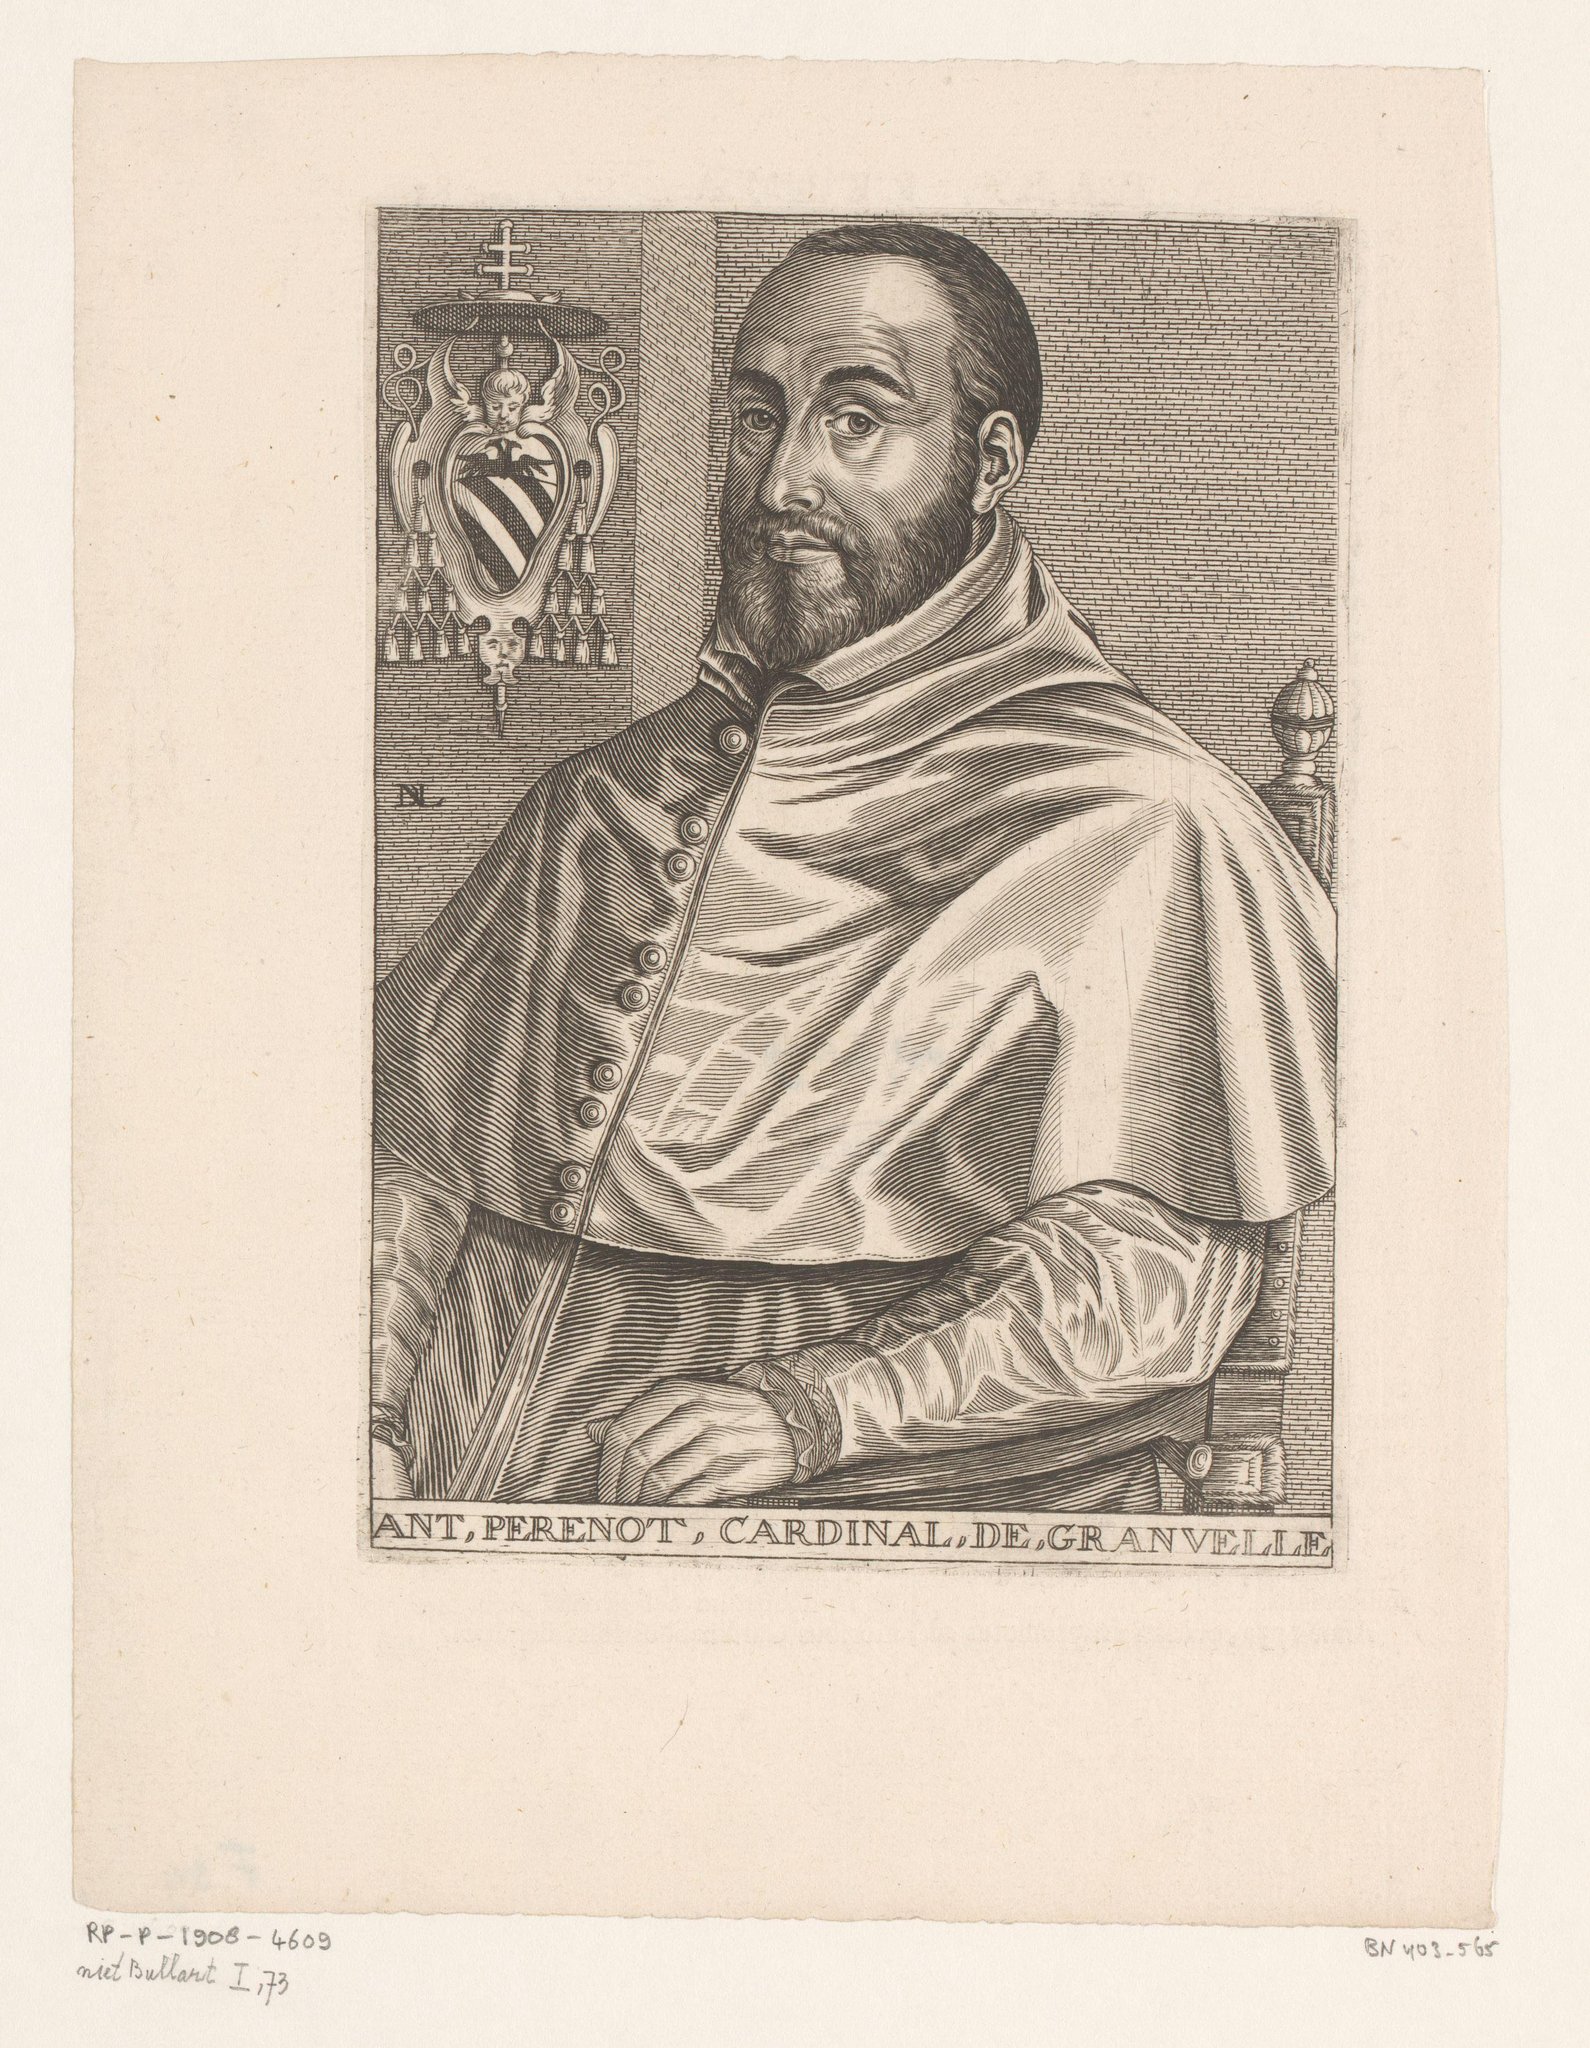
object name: print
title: Portret van Antoine Perrenot de Granvelle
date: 1682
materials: paper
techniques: engraving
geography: brussels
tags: antoine perrenot de granvelle, historical persons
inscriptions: collector's mark: Lugt 2228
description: Prent mogelijk gebruikt voor: Bullart, Isaac. Académie des Sciences et Arts contenant les vies et éloges his. des hommes illustres qui ont excellé en ces professions depuis environ quatre siècles. Brussel: François Foppens, 1682. Het boek werd in 1682 eveneens in Amsterdam uitgegeven door de erfgenamen van Daniel Elzevier. Ieder portret betreft een illustratie bij de biografie van een kunstenaar of geleerde. De meeste portretten werden door Nicolas de Larmessin vervaardigd (162), 93 door De Boulonois en een derde door ongeïdentificeerde prentmakers. Dit betreft een illustratie op p. 73, deel I.